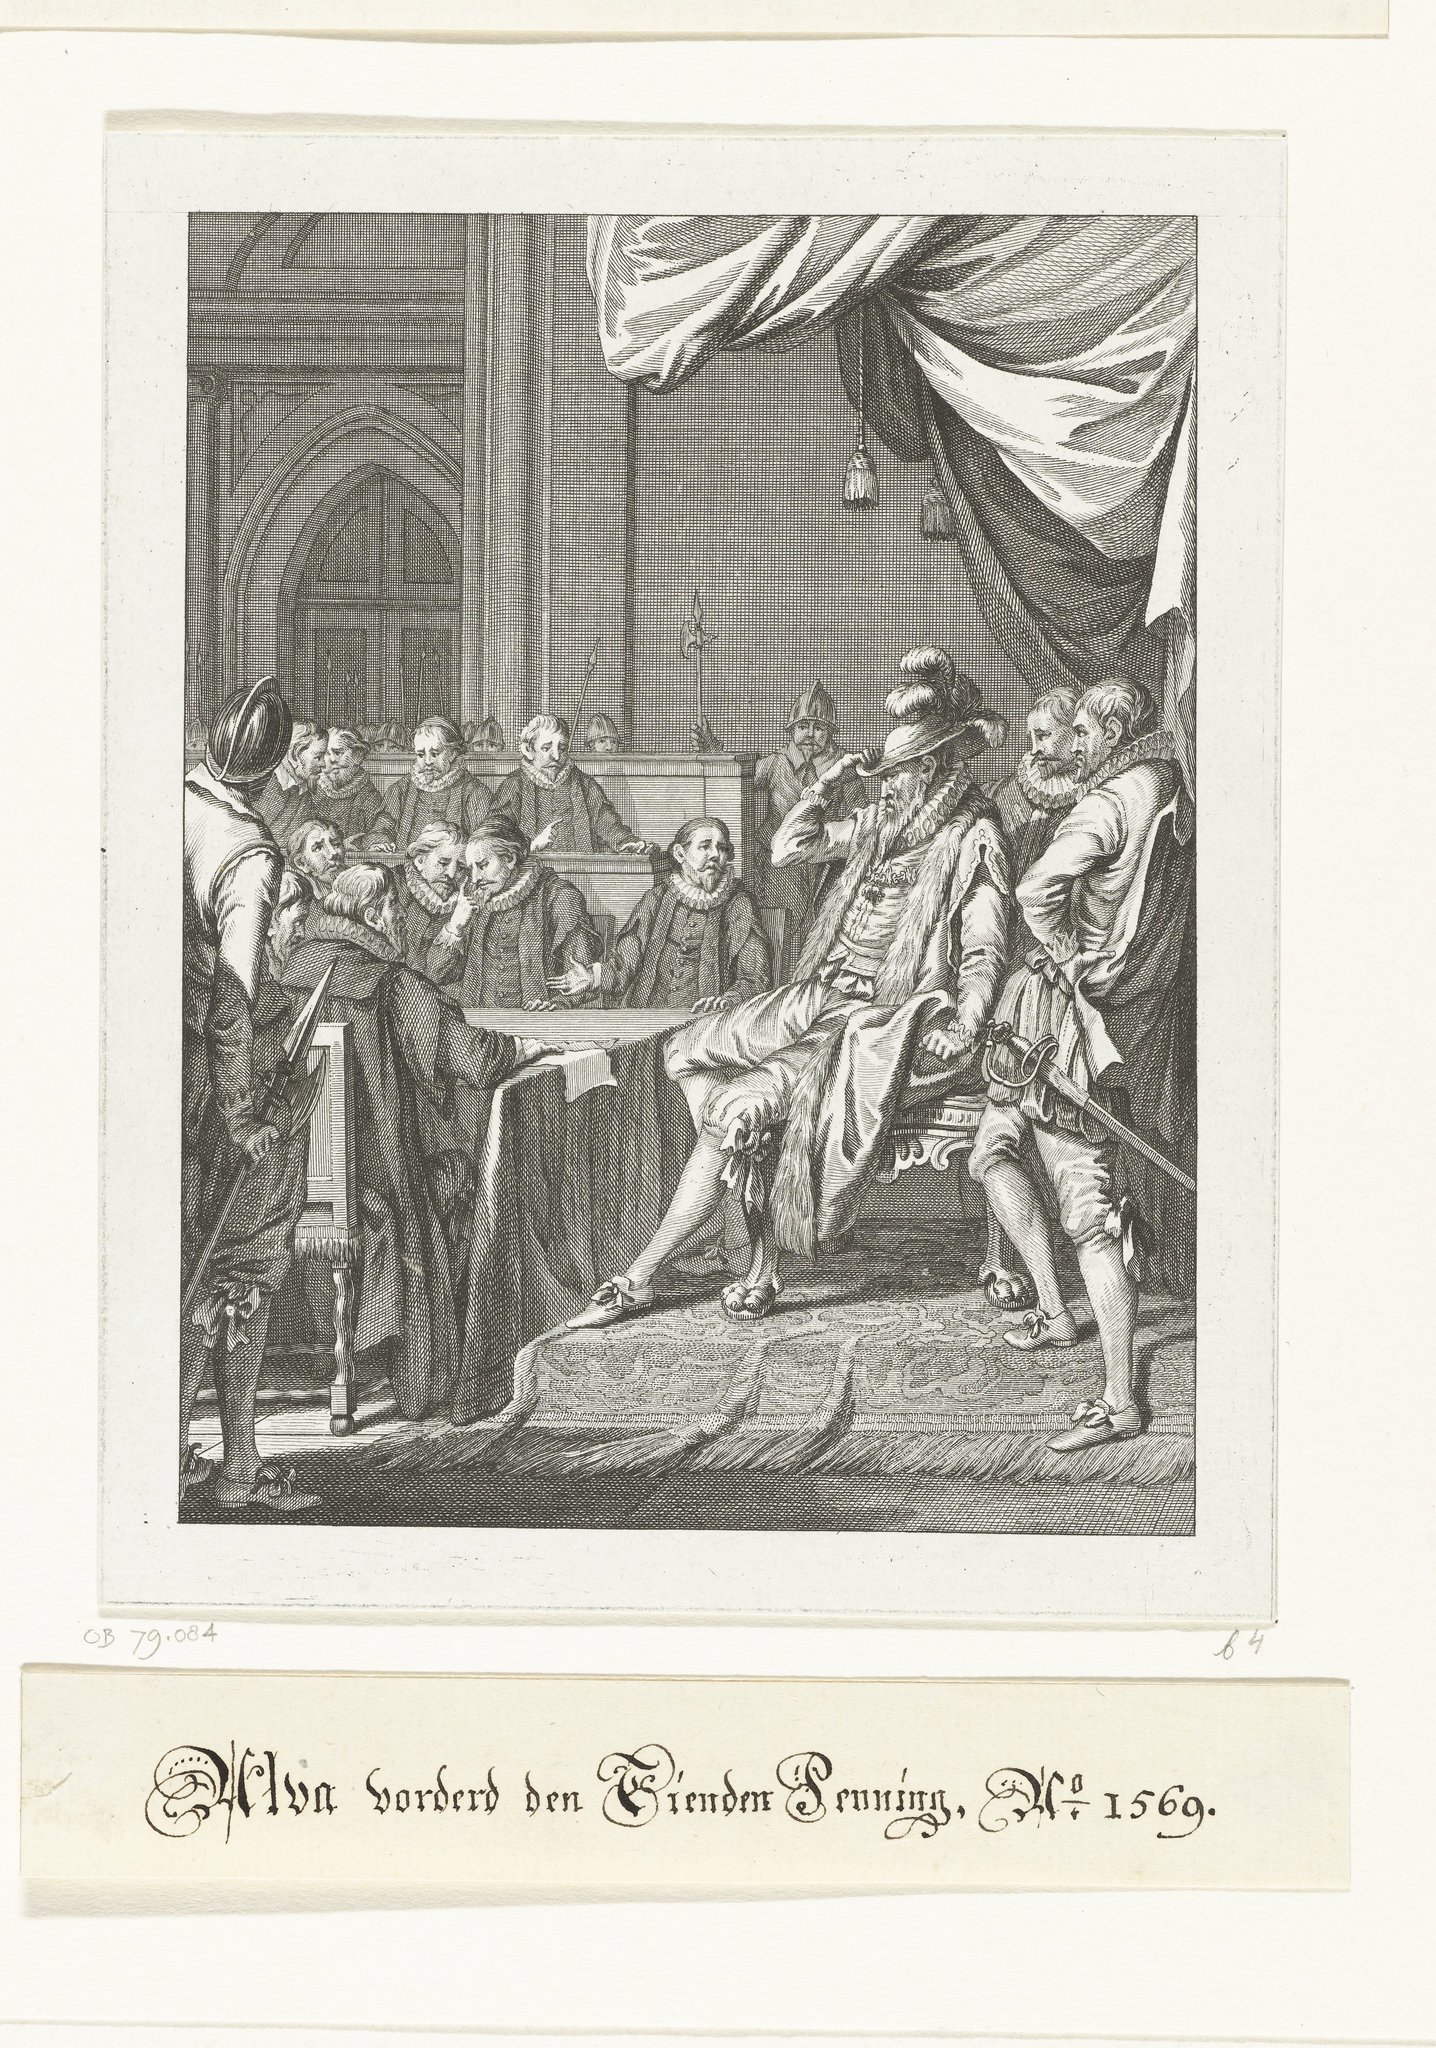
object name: print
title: Taferelen uit het leven van prins Willem I, 1568-1584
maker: theodoor koning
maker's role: print maker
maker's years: 1748-1829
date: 1779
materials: paper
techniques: etching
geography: northern netherlands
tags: fernando álvarez de toledo (3rd duke of alba)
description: Illustratie voor: J. Nomsz, Willem de eerste, of de grondlegging der Nederlandsche vryheid. : In vier en twintig zangen, Erven van David Klippink, Amsterdam 1779. Staat vóór de letter. Met de handgeschreven titel in pen in bruin op een apart papiertje.